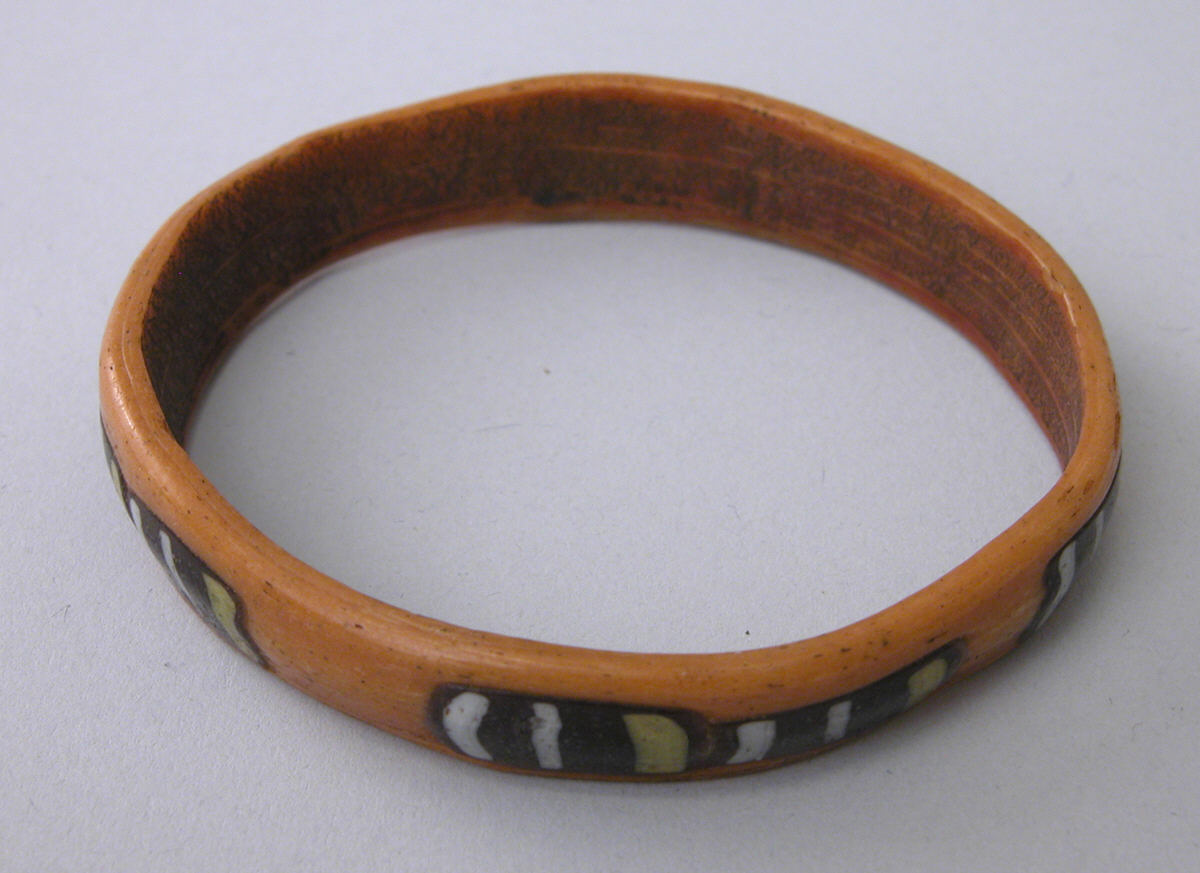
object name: bracelet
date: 1301-1500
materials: glass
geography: egypt or syria